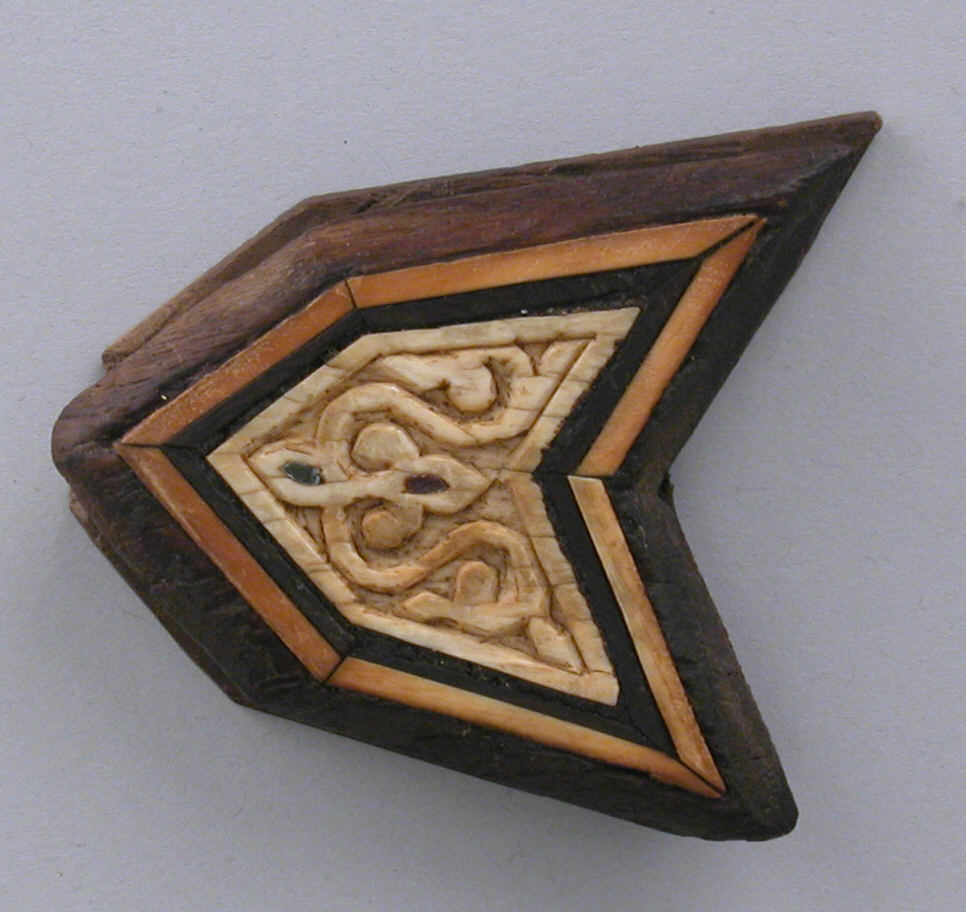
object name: panel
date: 1301-1500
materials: ivory, wood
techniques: carving, inlay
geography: egypt